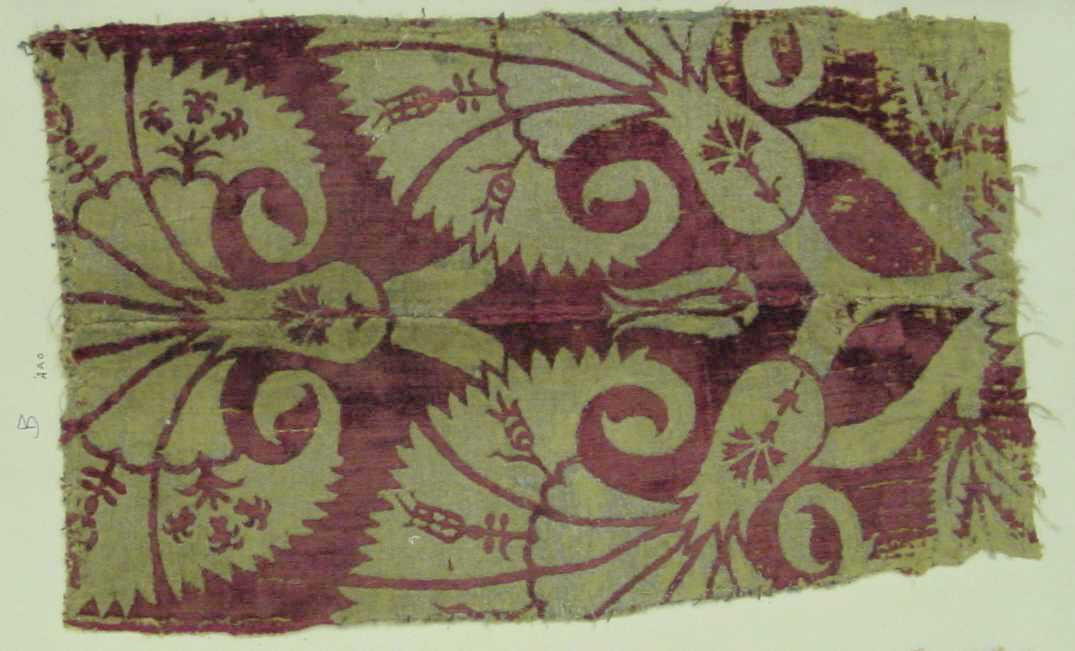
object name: textile fragment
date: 1567-1600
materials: metal thread, silk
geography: turkey